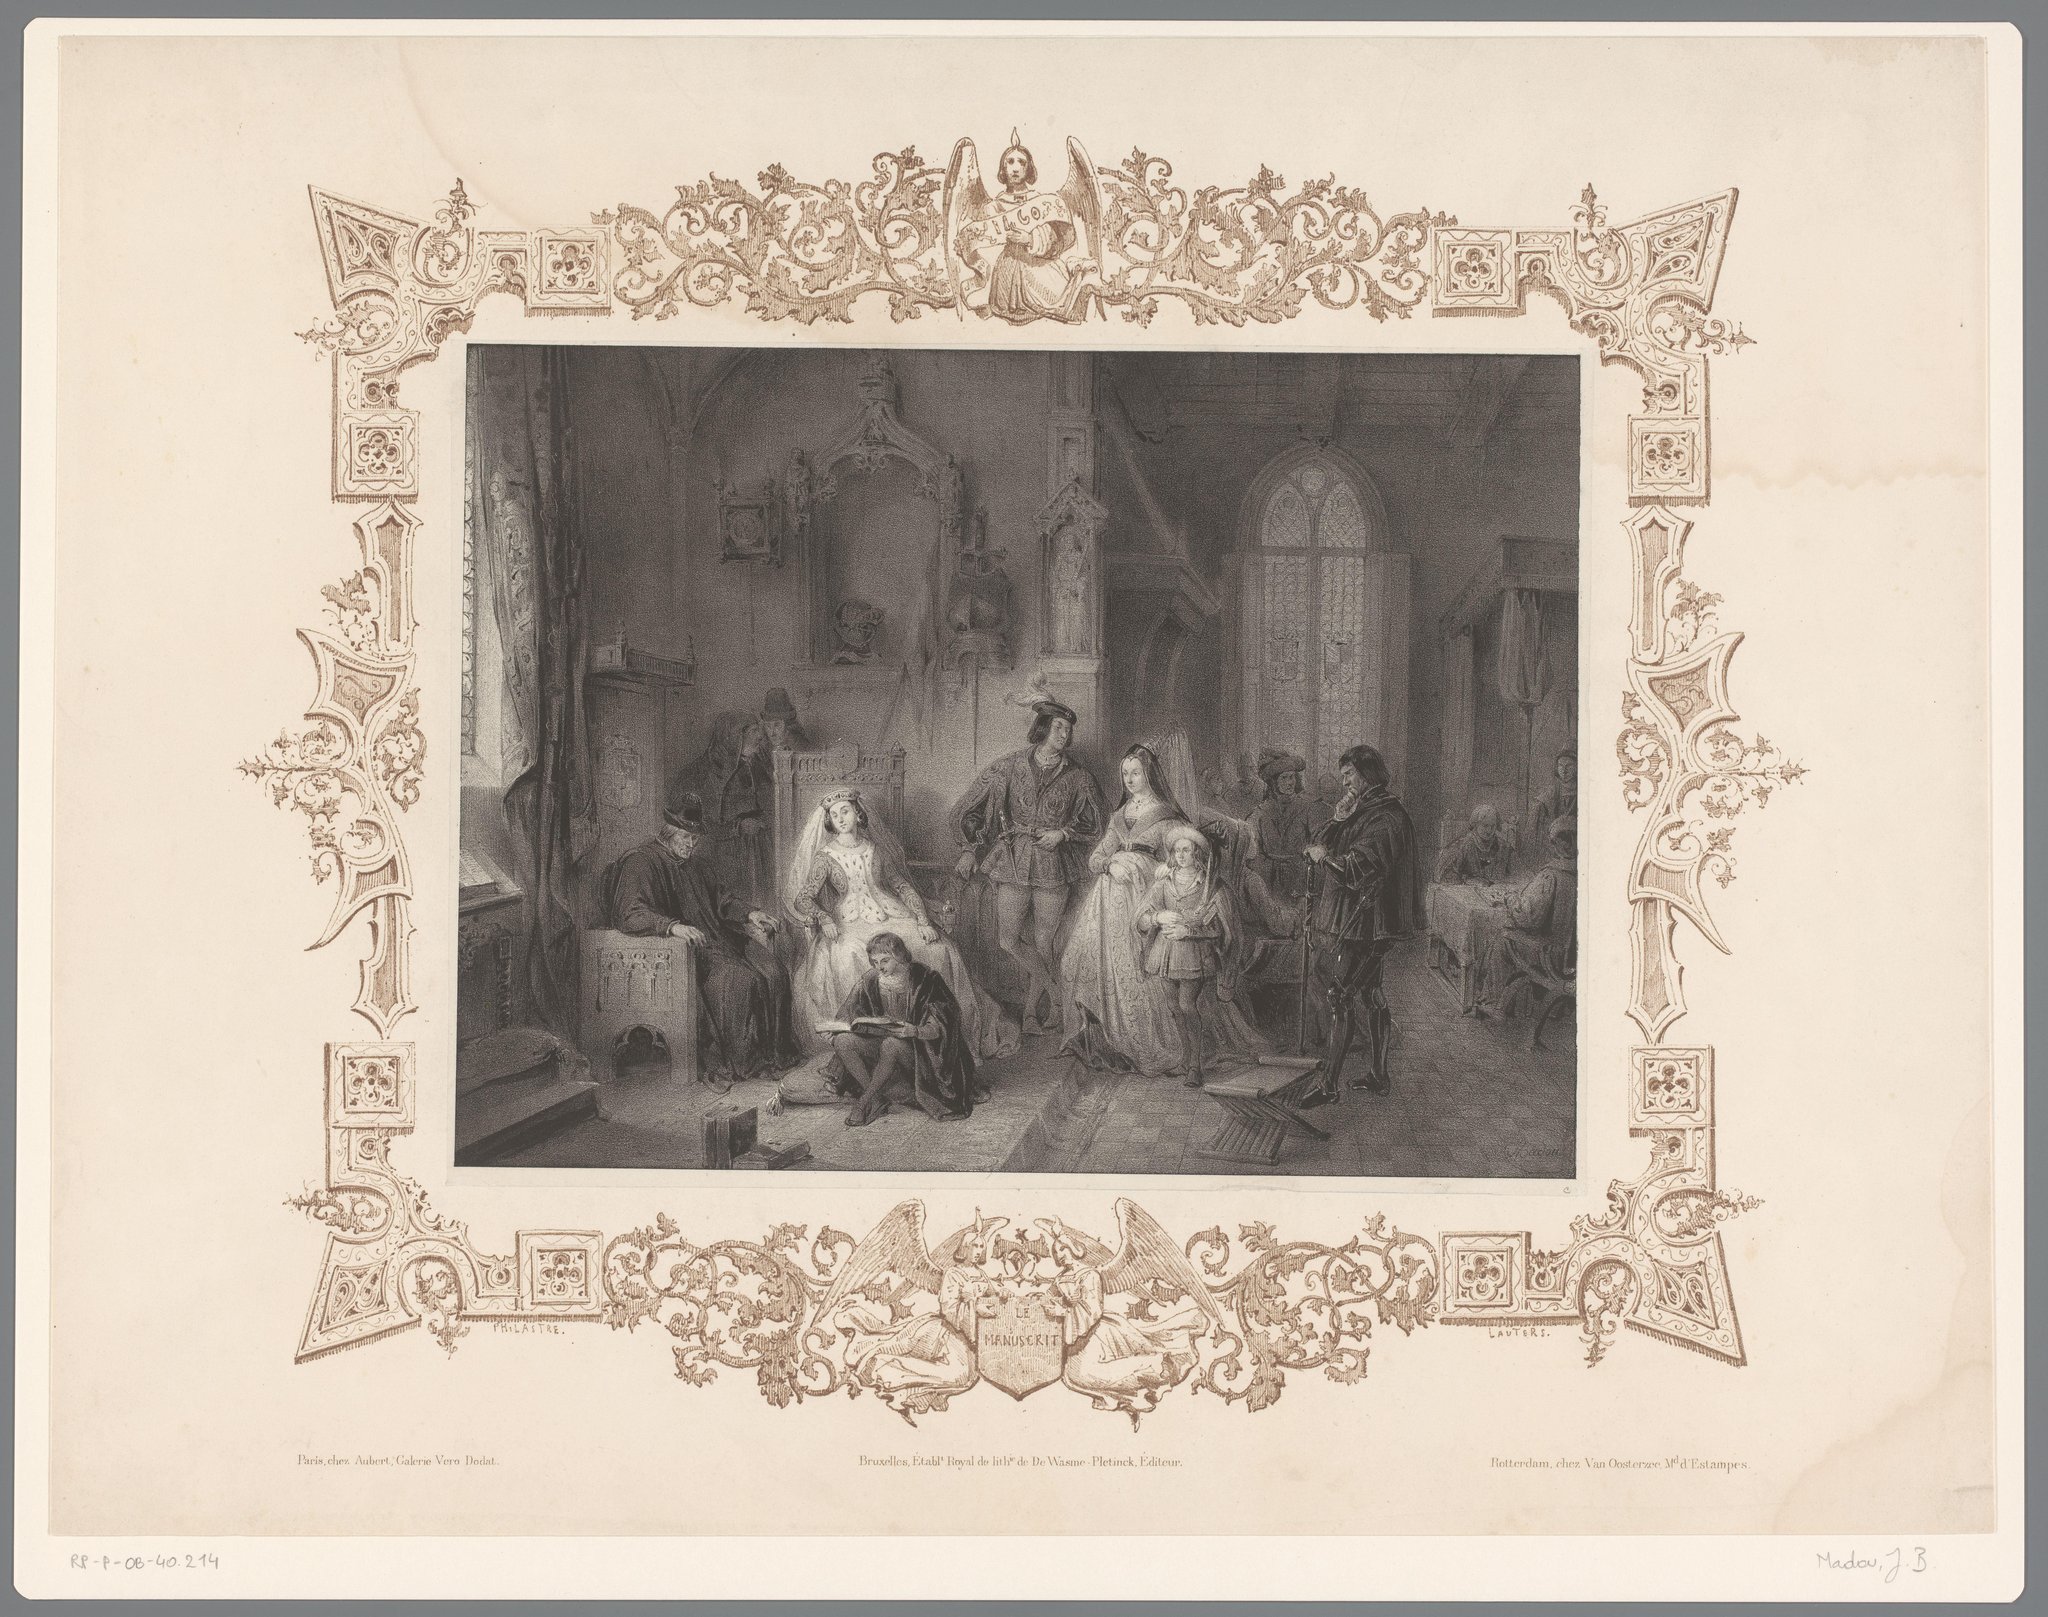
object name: print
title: Jongen leest in gezelschap een manuscript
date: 1835-1837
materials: paper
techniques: lithograph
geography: paris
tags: reading, youth, adolescent, handwriting, written text, interior of the house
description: De voorstelling is vervaardigd door Madou, de omlijsting door Paulus Lauters en Philastre.